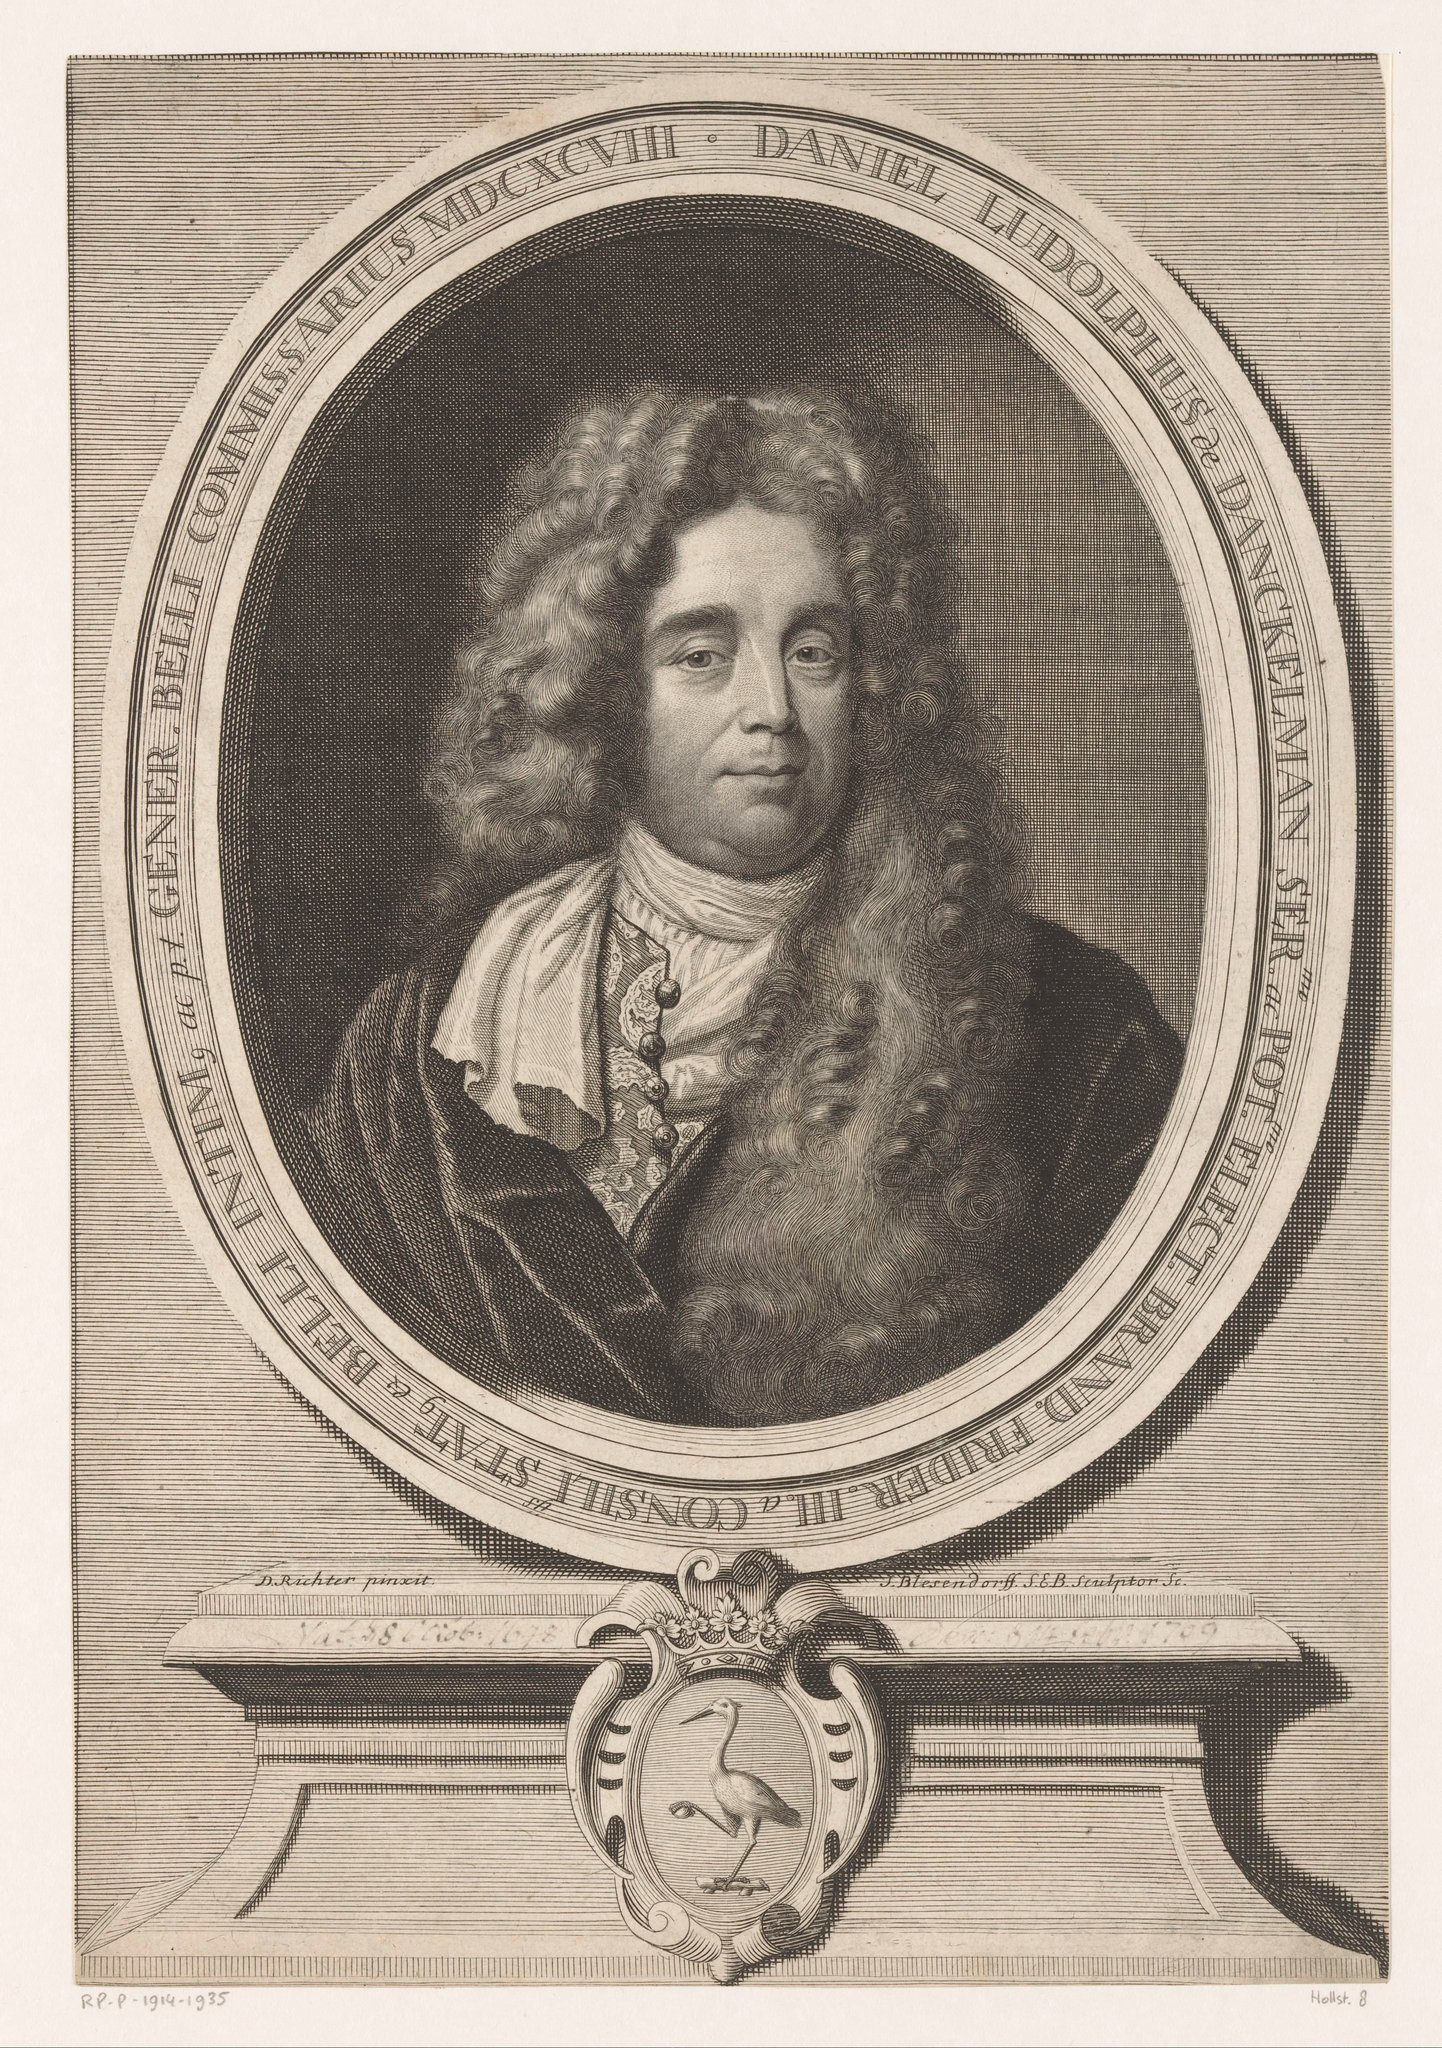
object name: print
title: Portret van Daniel Ludolph, Freiherr von Danckelman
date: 1698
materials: paper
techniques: engraving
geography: berlin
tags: berlin, official, historical persons, armorial bearing, heraldry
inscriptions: collector's mark: Lugt 2228